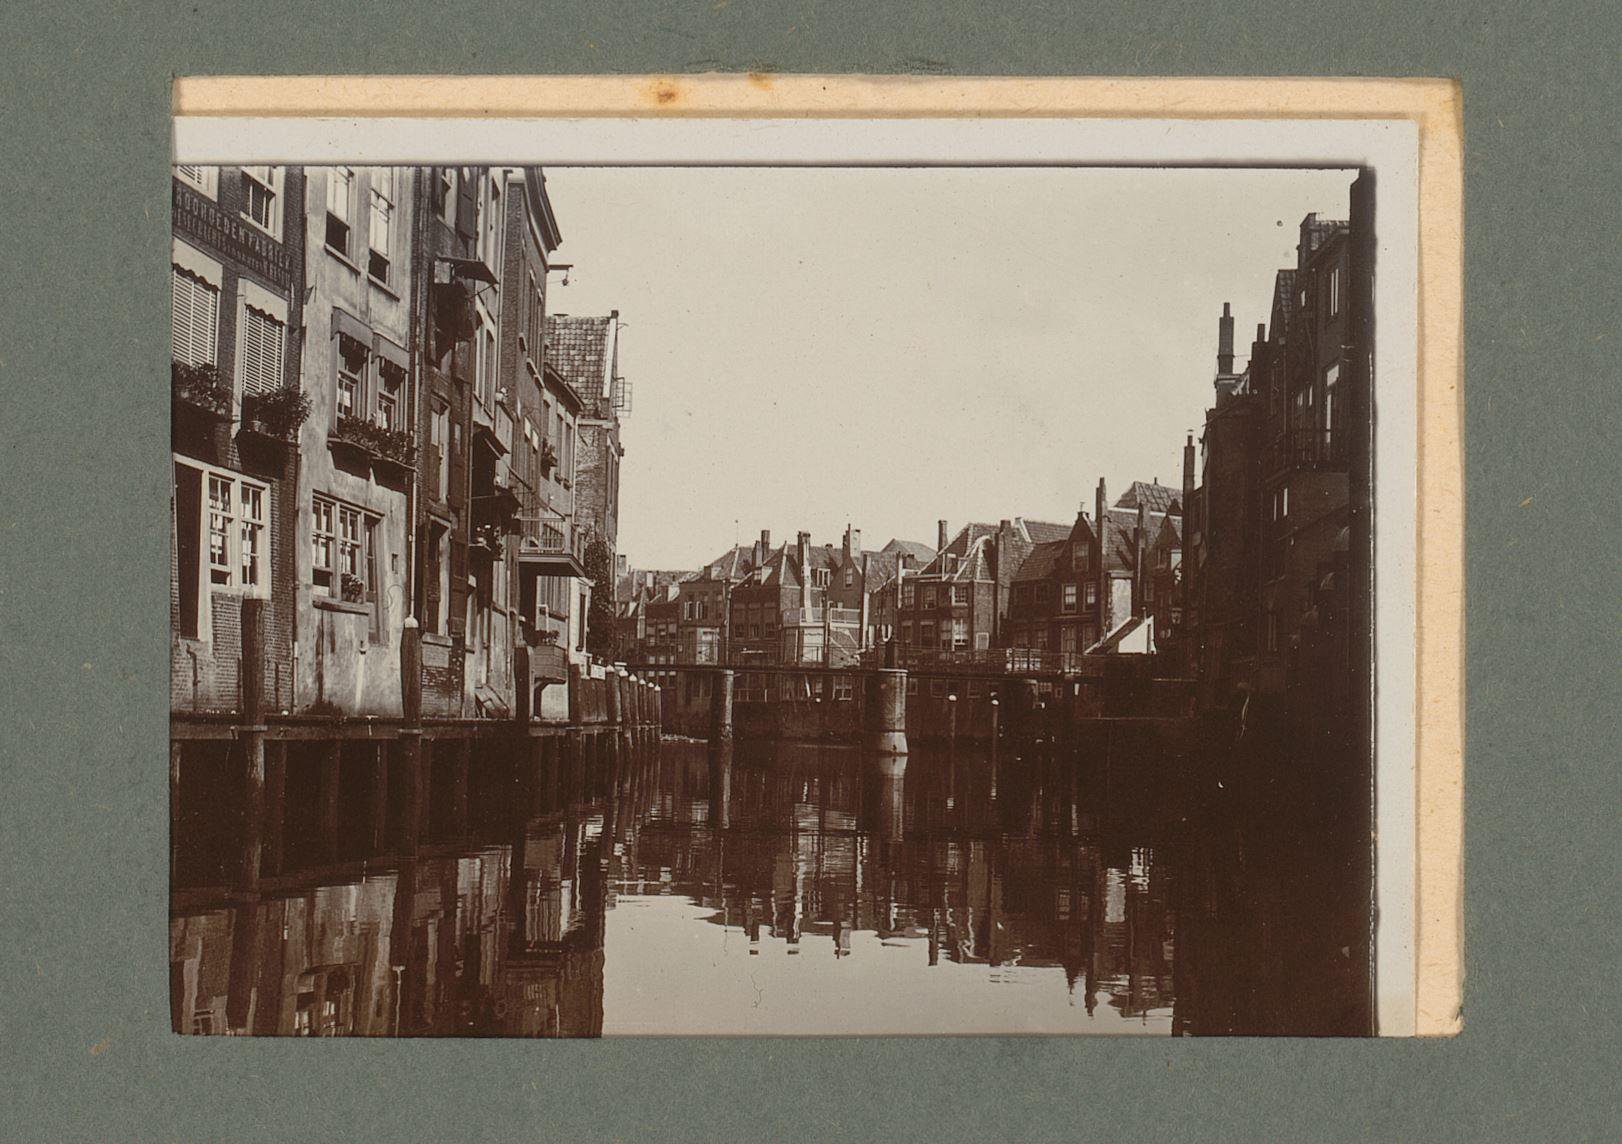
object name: album leaf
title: Gezicht op de Wijnhaven en de Wijnbrug te Dordrecht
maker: george hidderley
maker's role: fotograaf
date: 1900-1920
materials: photographic support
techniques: gelatin silver print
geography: netherlands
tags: urban housing, canals, waters (in city), bridge in city across river, canal, etc., dordrecht